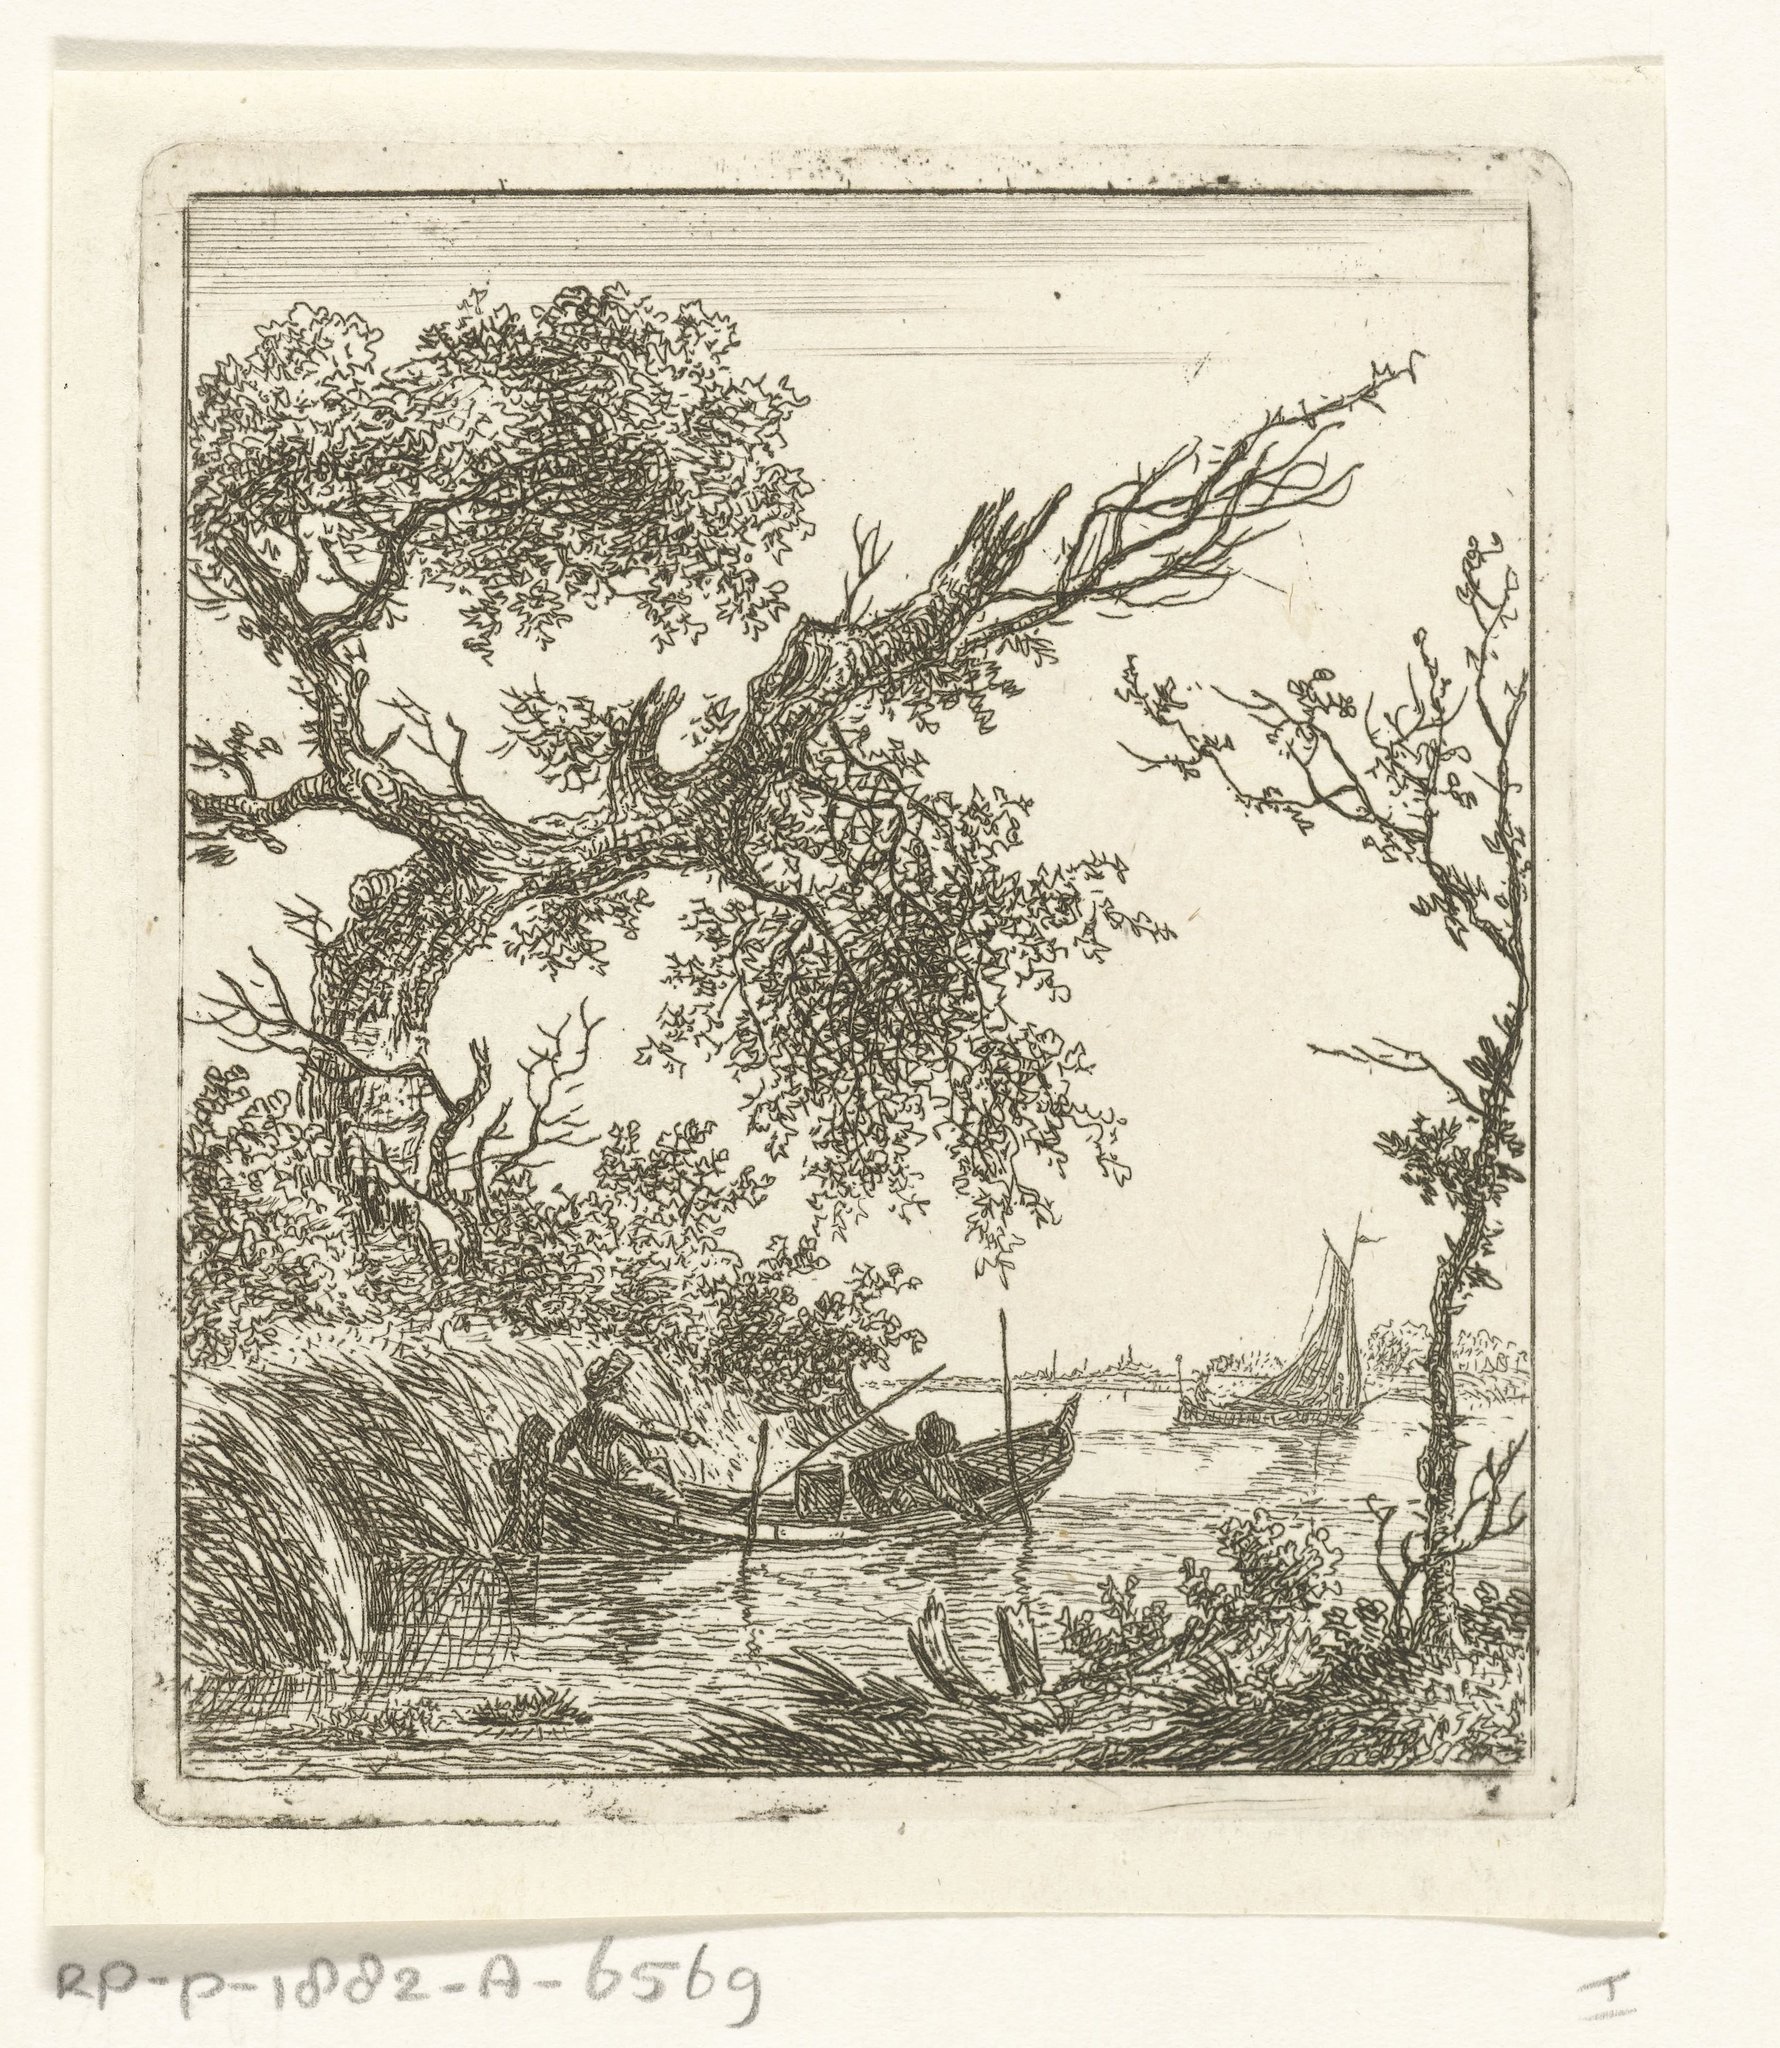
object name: print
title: Roeiboot met twee mannen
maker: hermanus fock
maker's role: conservator, draughtsman, painter, print maker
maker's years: 1766-1822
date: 1781-1822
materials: paper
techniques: etching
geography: amsterdam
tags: rowing-boat, canoe, etc.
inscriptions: collector's mark: Lugt 2228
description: Een gezicht op een grote overhangende boom en een roeiboot waar twee mannen in zitten. Op de achtergrond een zeilschip.